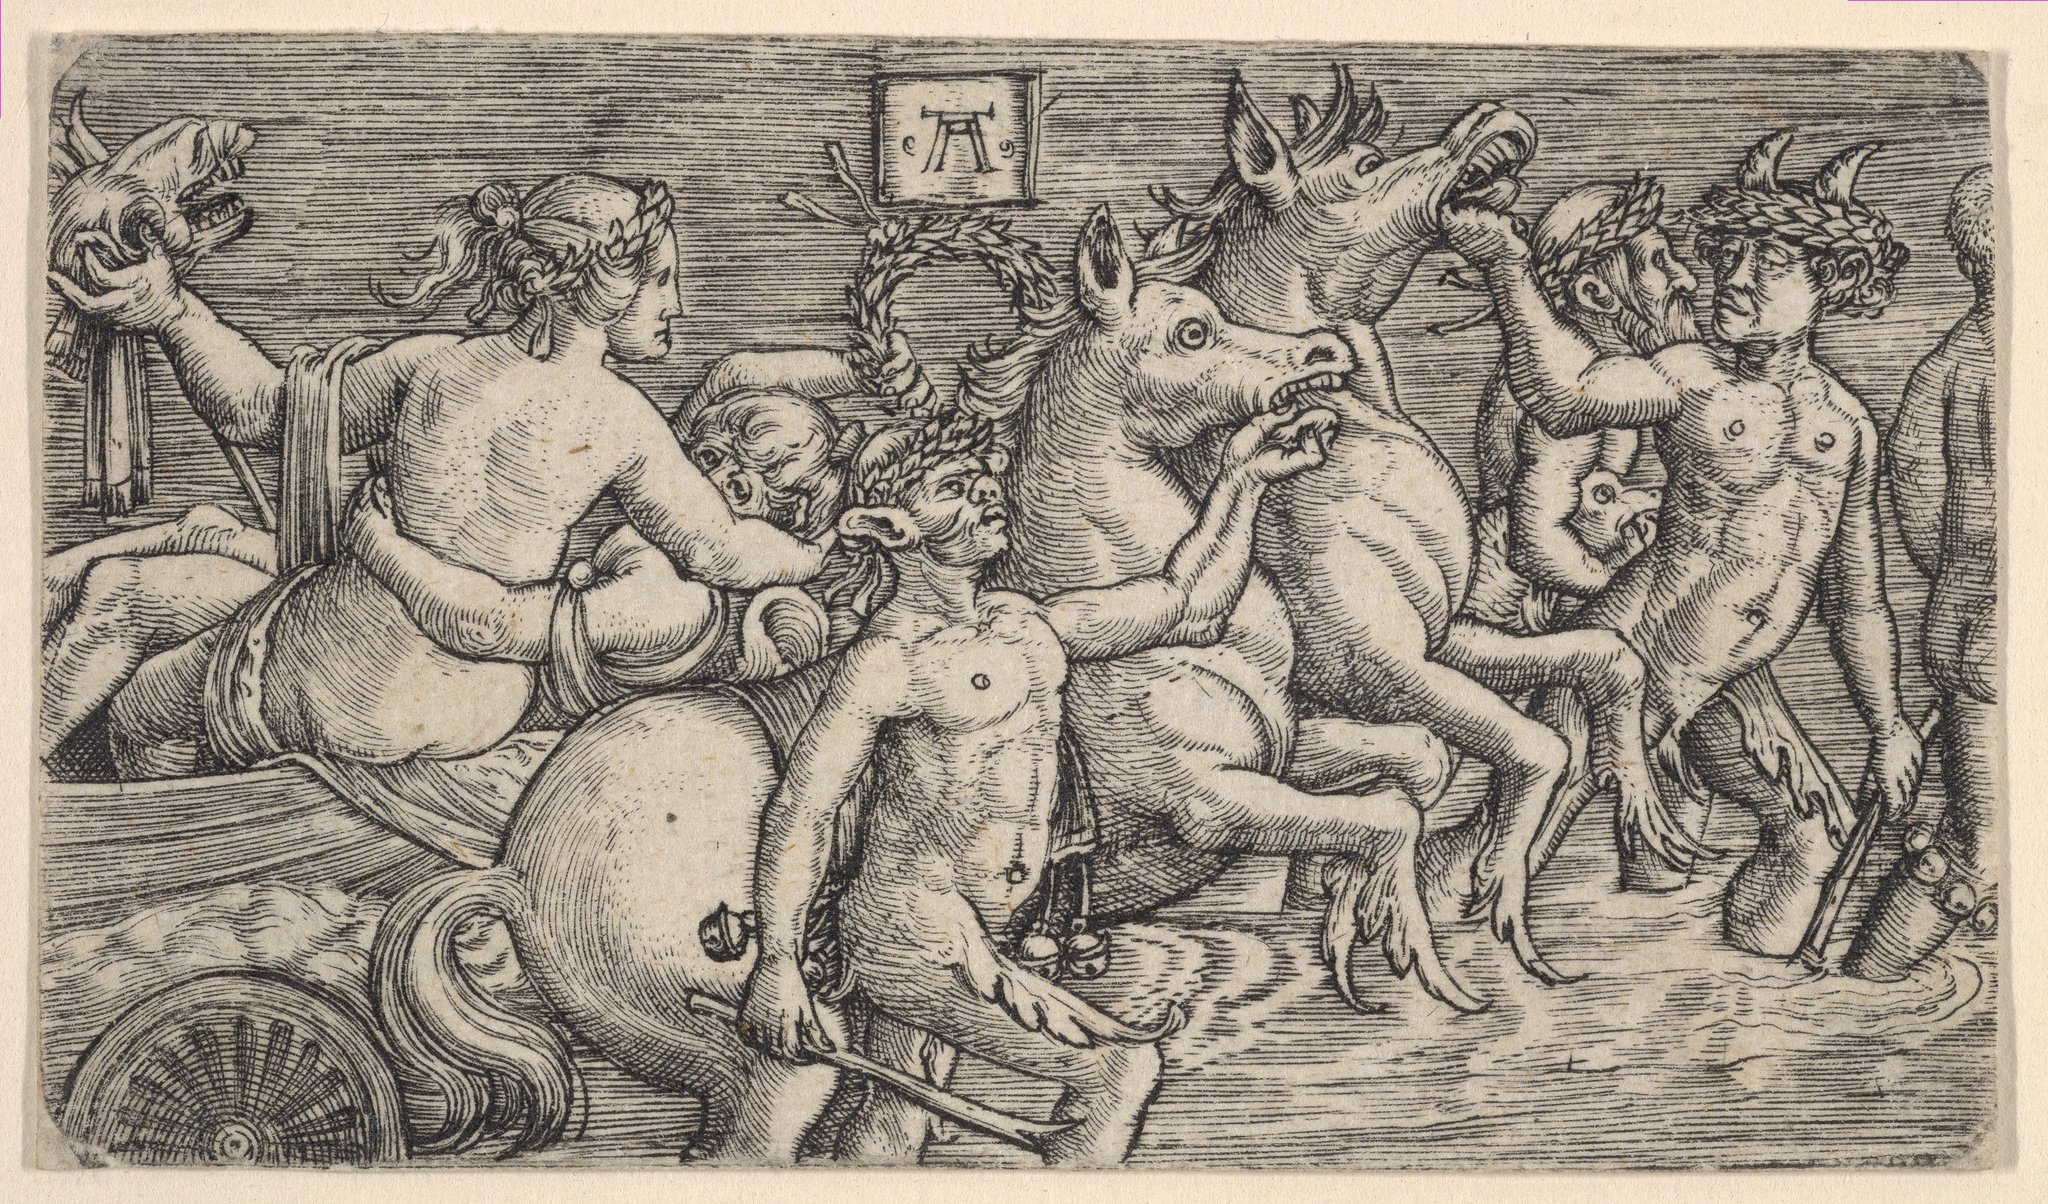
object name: print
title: The Triumph of the Sea-Gods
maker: albrecht altdorfer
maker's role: artist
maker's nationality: german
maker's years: 1480-1538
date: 1500-1538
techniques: engraving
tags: horses,chariots